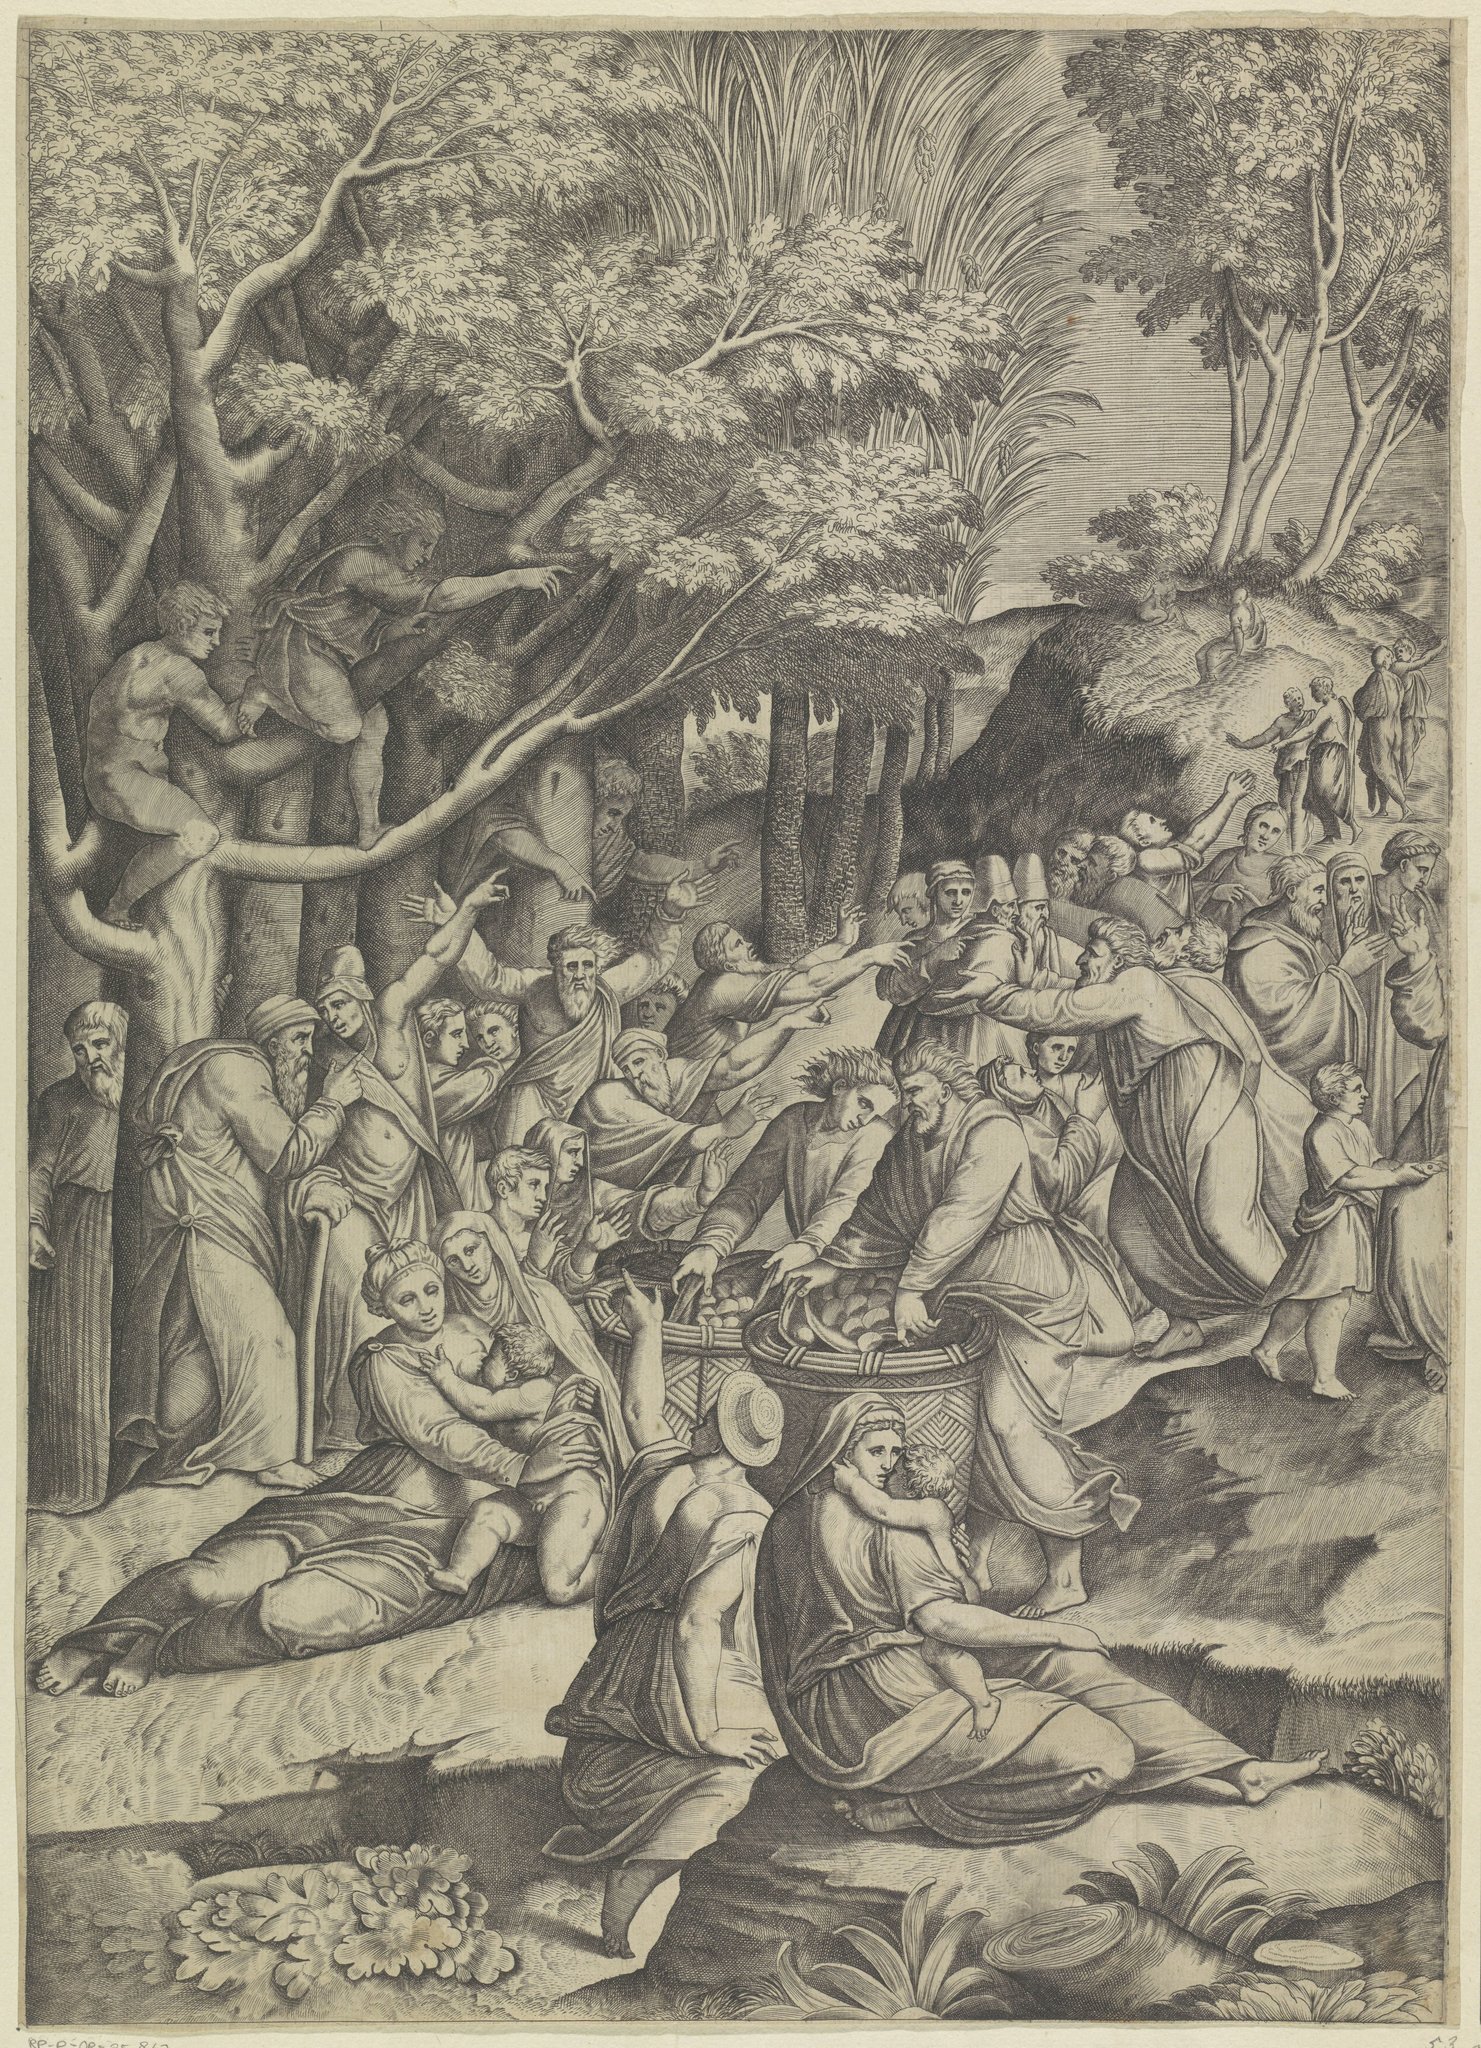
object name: print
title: De Wonderbare Spijziging (linkerdeel)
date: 1535-1601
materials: paper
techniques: engraving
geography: italy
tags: city-view, and landscape with man-made constructions, river, multiplication of loaves and fishes for a multitude of four or five thousand people (matthew 14:13-21, 15:32-39; mark 6:32-44, 8:1-10; luke 9:10-17; john 6:1-14)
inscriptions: collector's mark: Lugt 240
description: Christus vermenigvuldigt de broden en de vissen, te midden van zijn discipelen en toeschouwers. Op de achtergrond een landschap met een rivier en huizen.